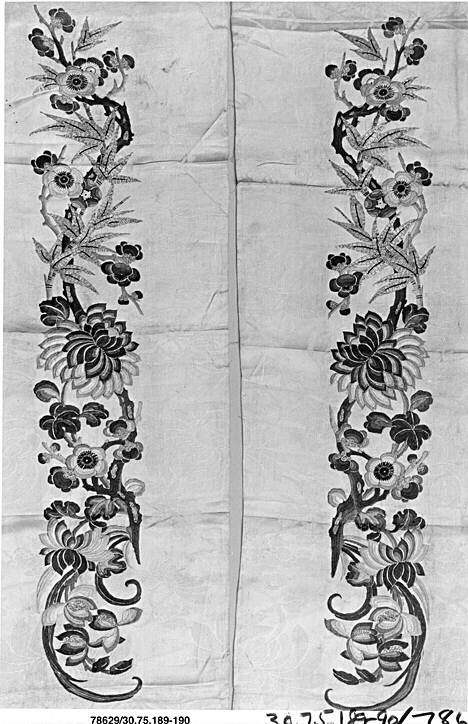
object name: sleeve band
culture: chinese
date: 1801-1900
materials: metal thread, silk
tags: flowers